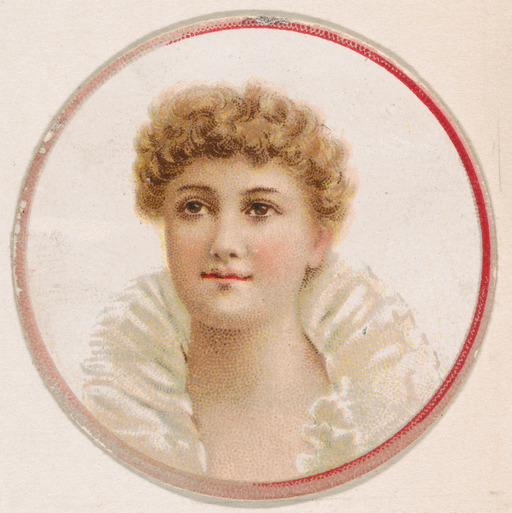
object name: print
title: Portrait of woman, from the Novelties series (N228, Type 2) issued by Kinney Bros.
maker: kinney brothers tobacco company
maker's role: publisher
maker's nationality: american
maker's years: 1869-2011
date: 1889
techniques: color lithograph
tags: portraits,women